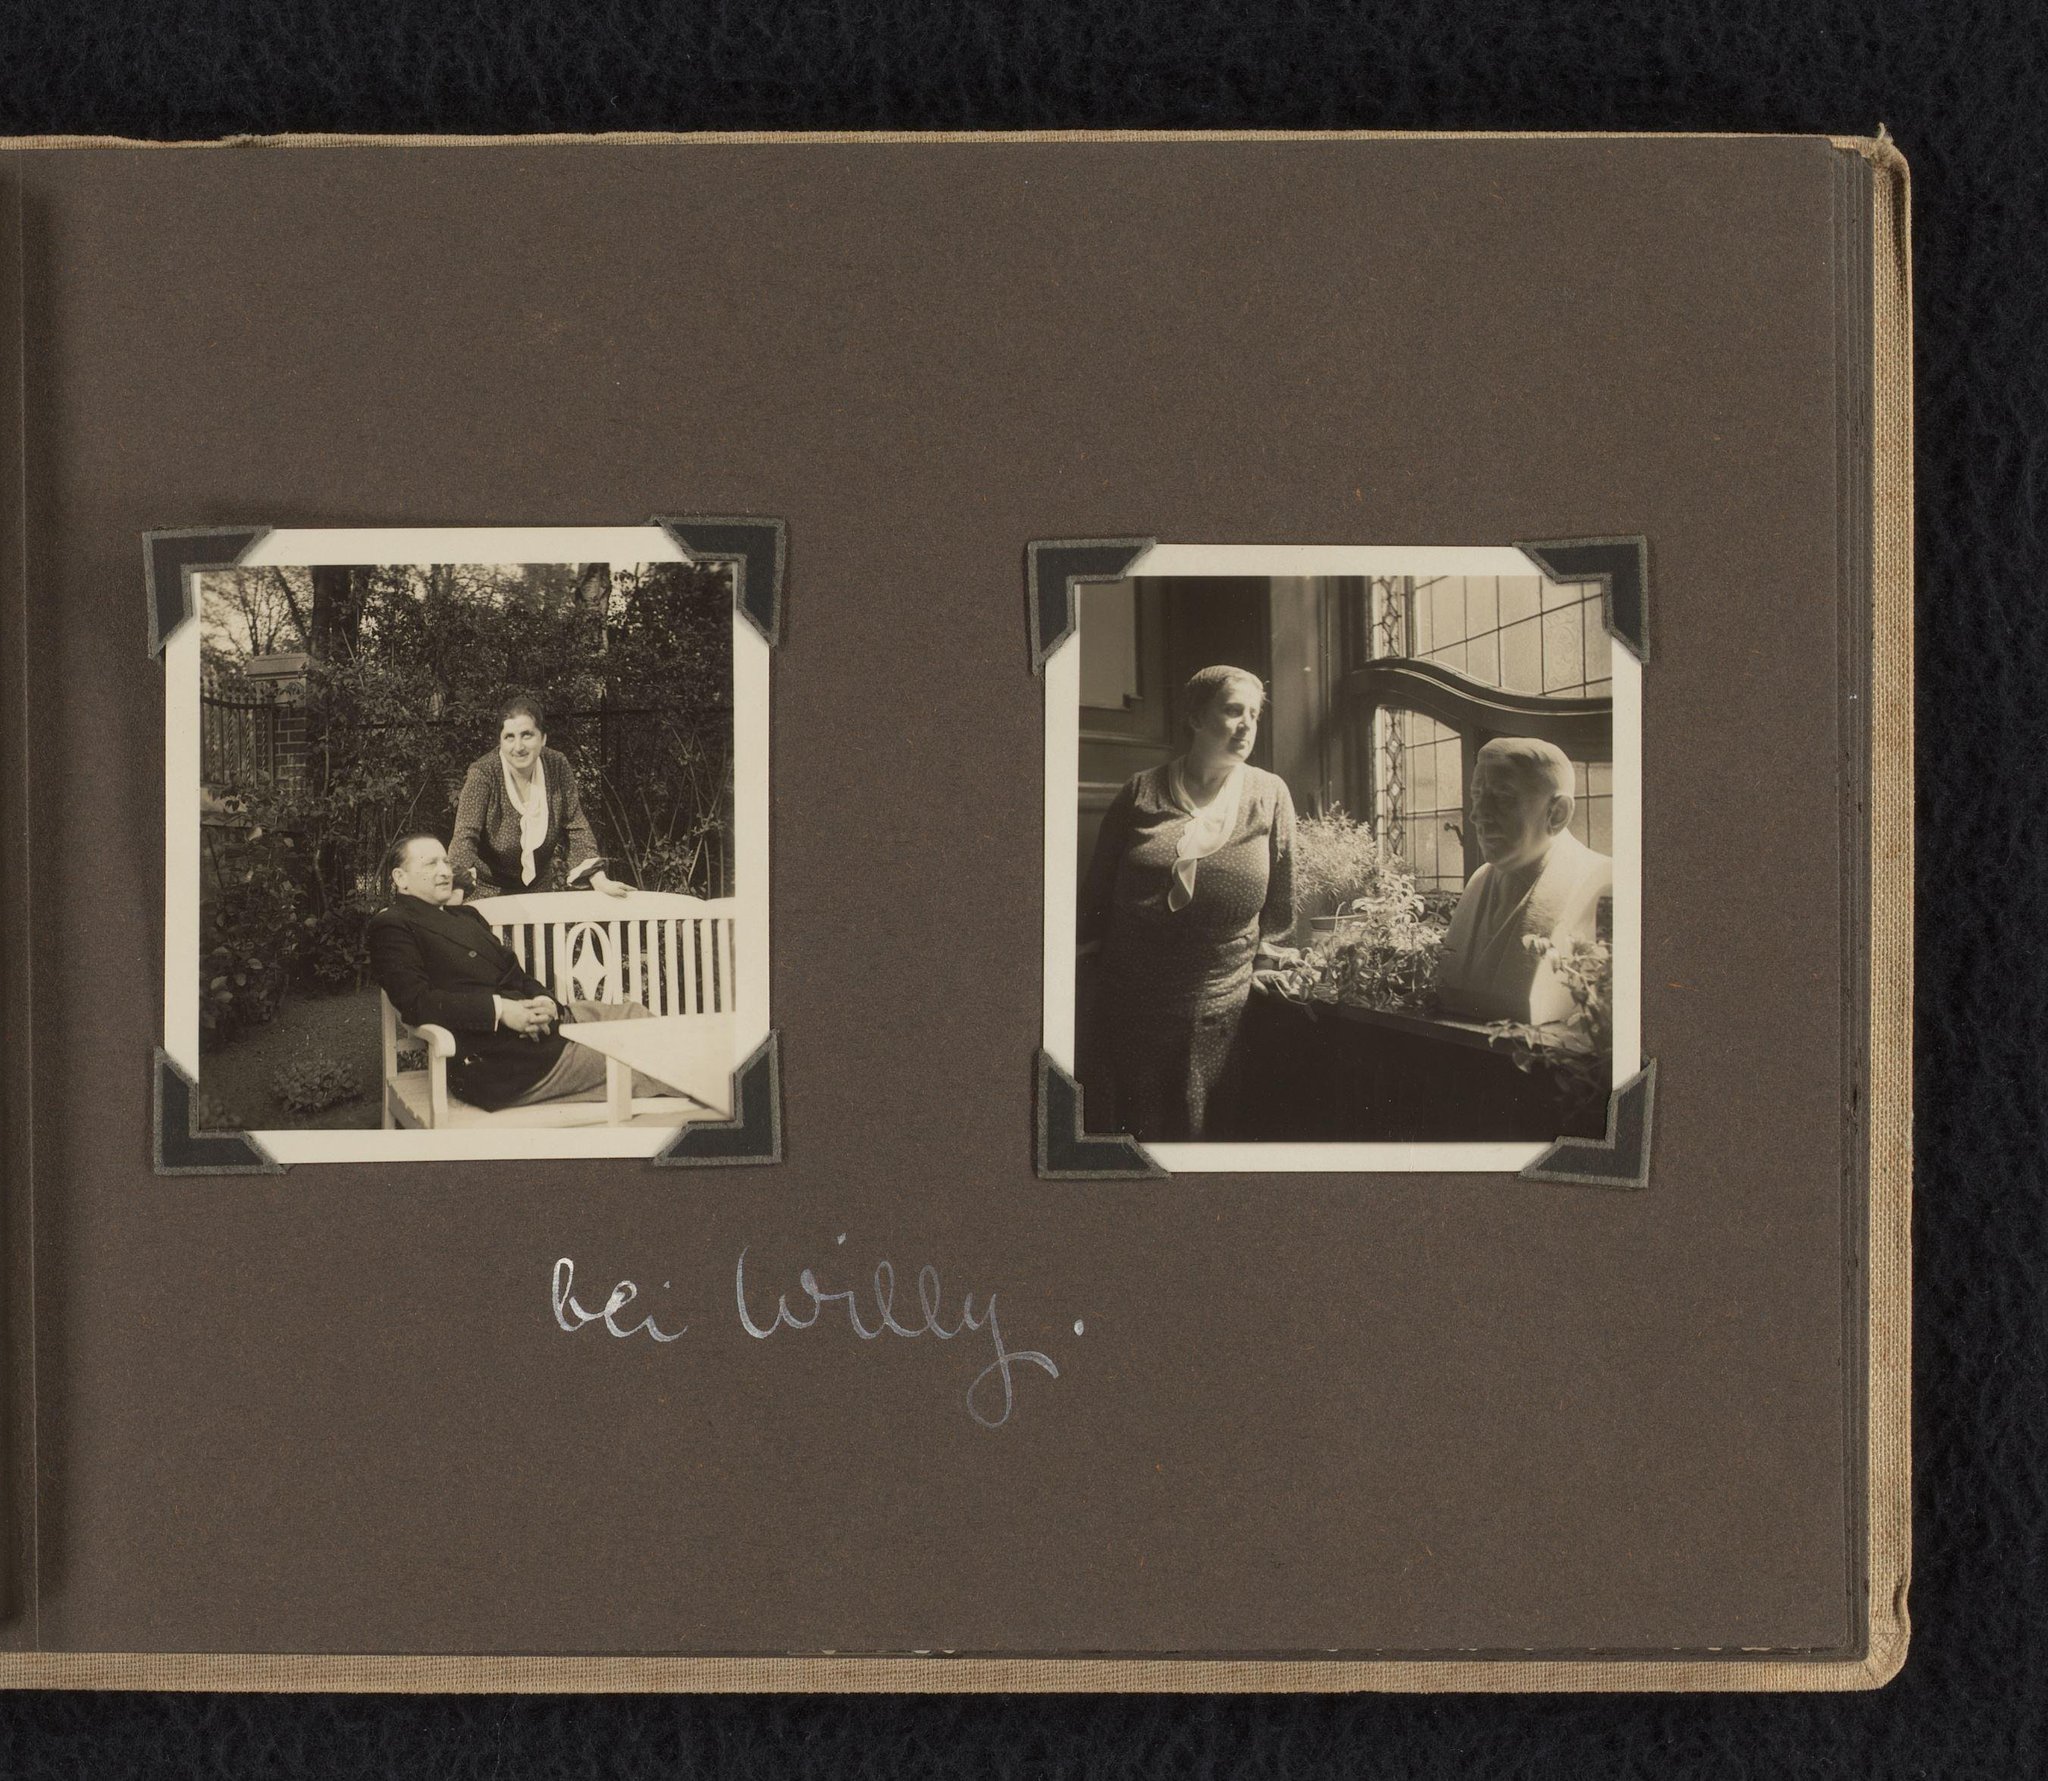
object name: album leaf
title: Else Wachenheimer-Moos en haar broer Willy Moos in de tuin en de woning van Willy, met onder meer een buste van hun vader Hermann Moos, maart-mei 1932, Hamburg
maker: else wachenheimer-moos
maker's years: 1895-1944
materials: cardboard, photographic support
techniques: gelatin silver print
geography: hamburg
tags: else wachenheimer-moos, willy moos, piece of sculpture, reproduction of a piece of sculpture, family life at home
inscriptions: inscription: ‘bei Willy’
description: Blad bevat twee foto's. Alle foto's van Else Wachenheimer-Moos en Willy Moos. Uit het album, half formaat, crèmekleurig stofomslag met koordbinding met banenmotief.